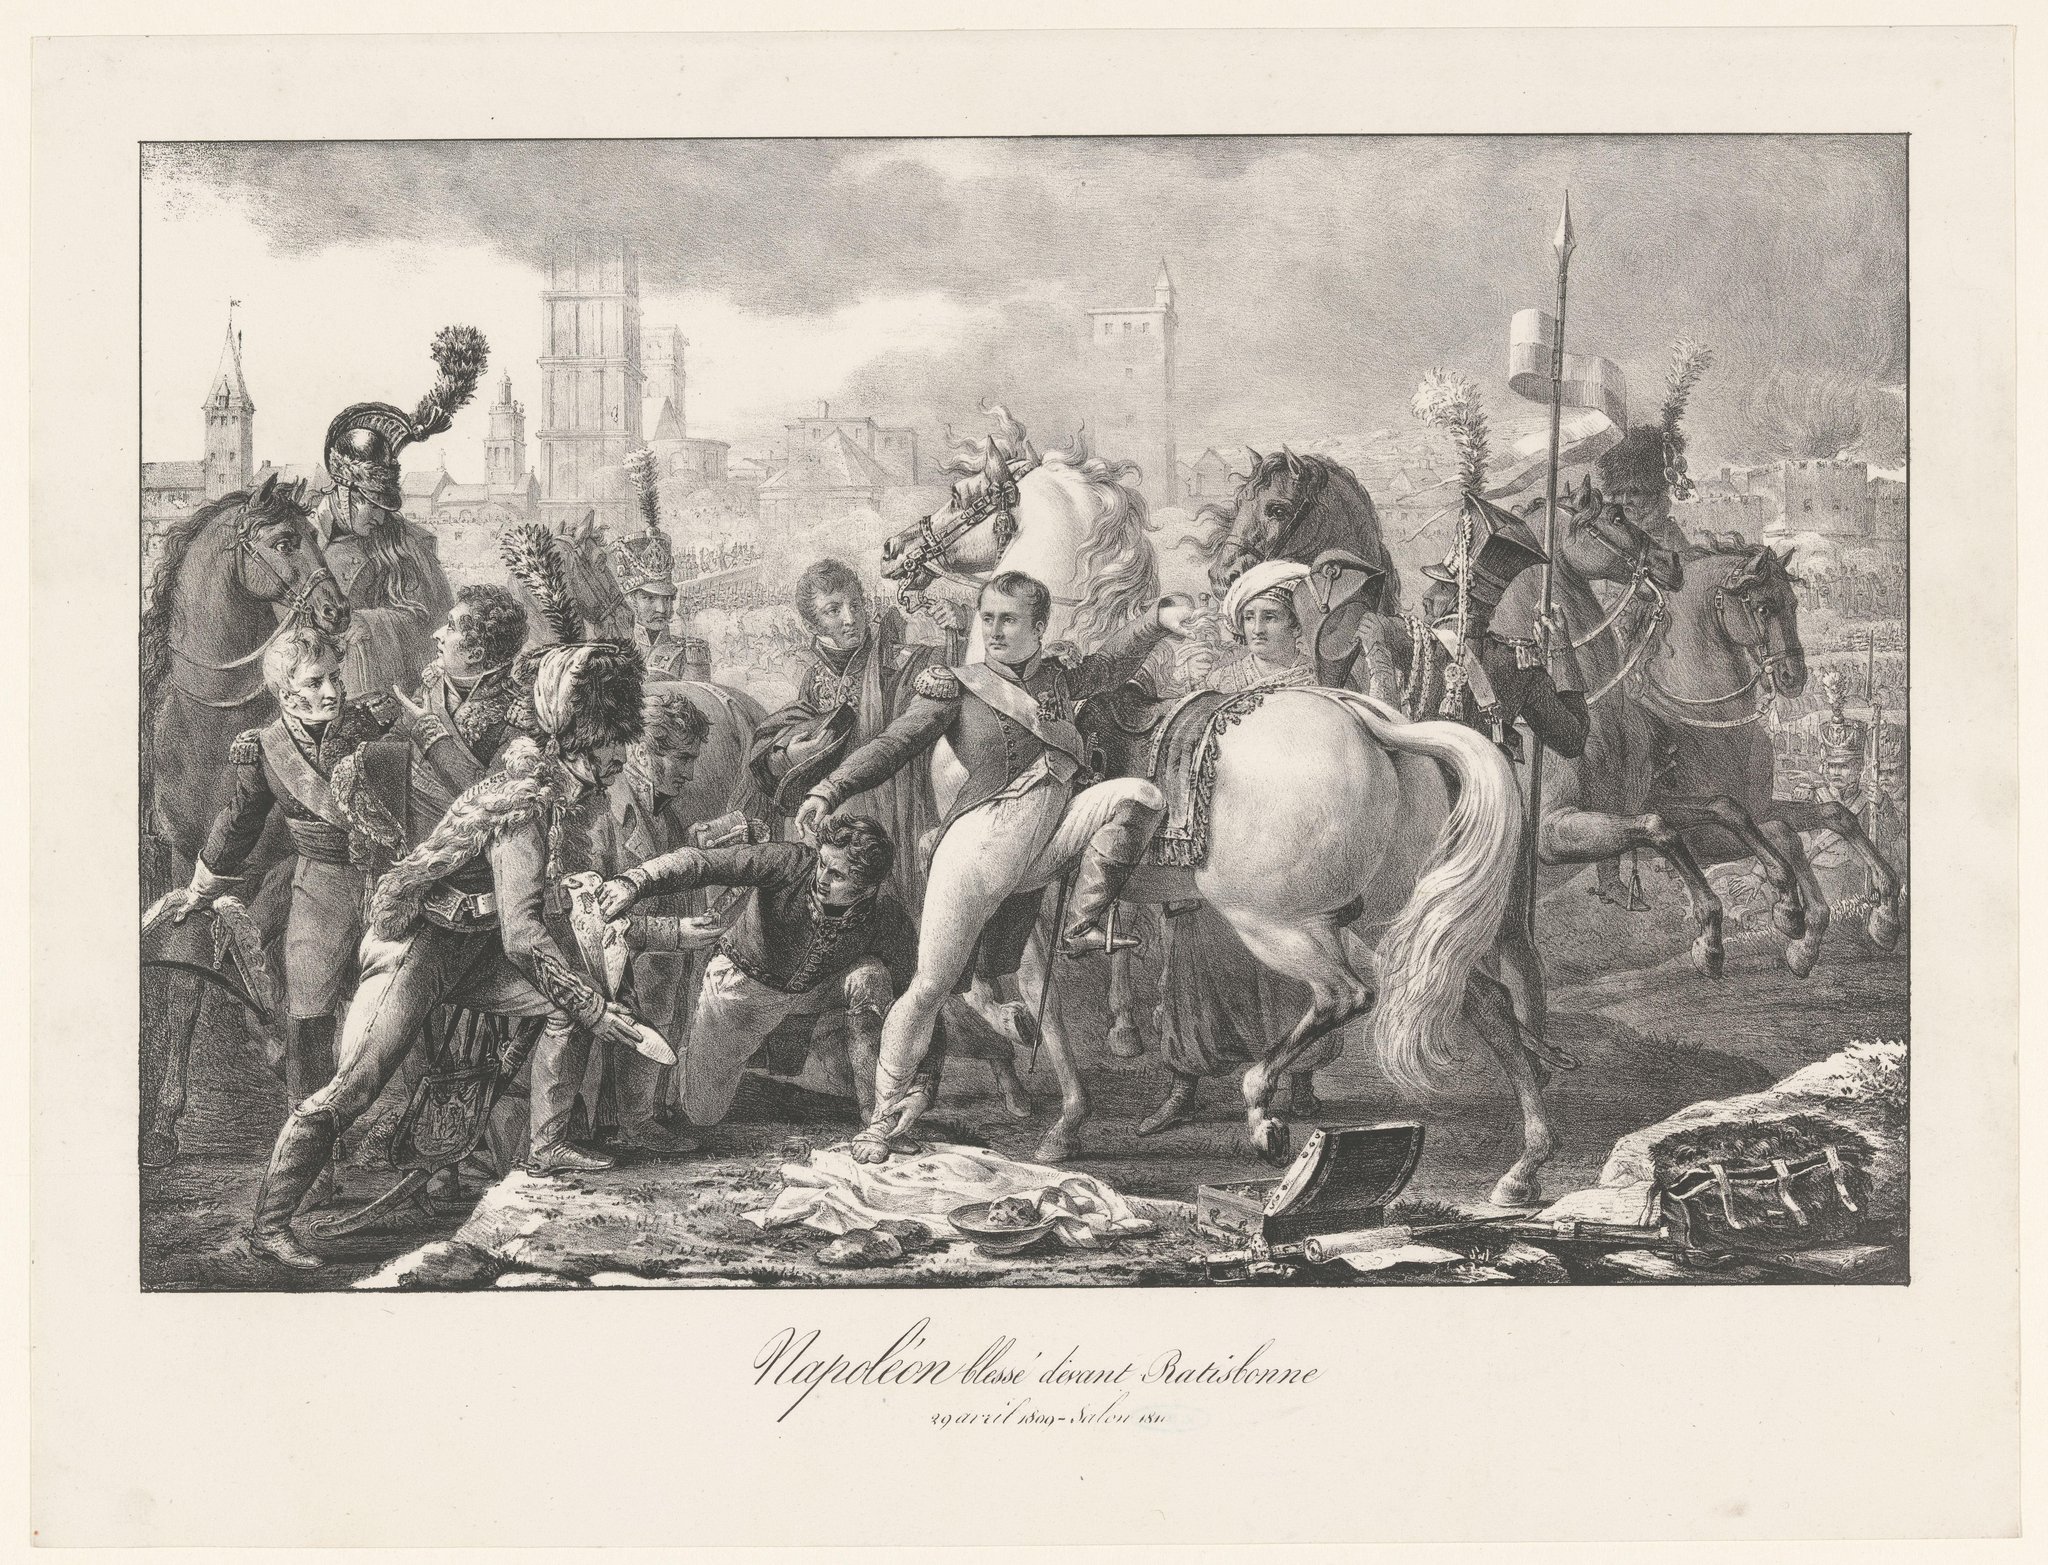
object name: print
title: Napoleon gewond tijdens de slag bij Regensburg, 1809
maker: Anonymous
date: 1811-1899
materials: paper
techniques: lithograph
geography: france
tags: napoleon i (emperor of the french), medical aid and nursing of the sick and wounded, battle (+ land forces)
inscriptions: collector's mark: Lugt 2228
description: Keizer Napoleon raakt aan zijn enkel gewond tijdens de slag bij Regensburg (Ratisbonne), 23 april 1809. Naar het schilderij van 1810 door Gautherot.